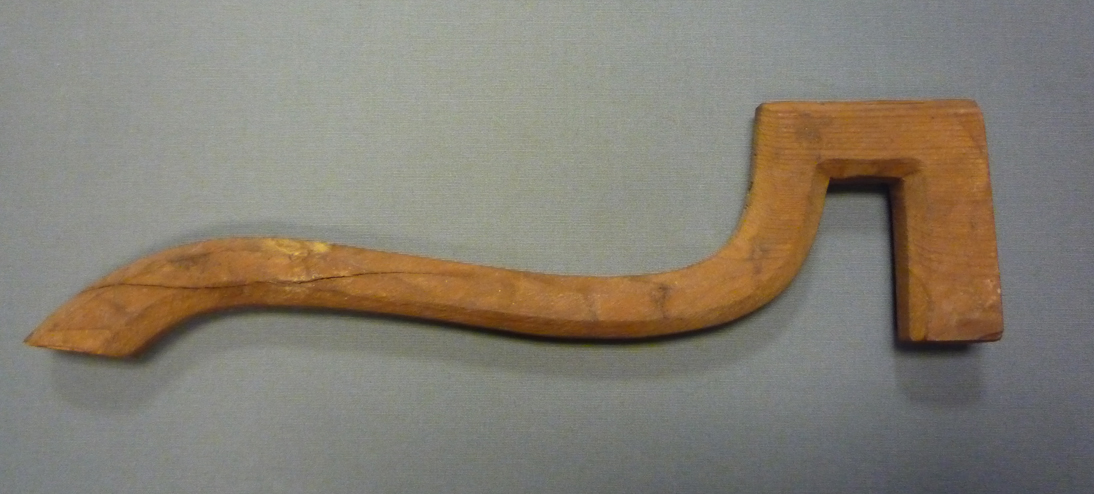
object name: tool, mesekhetyu, hatshepsut foundation deposit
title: Meskhetyu Instrument From Foundation Deposit C, Hatshepsut's Temple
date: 1479-1458 BCE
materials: wood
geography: egypt